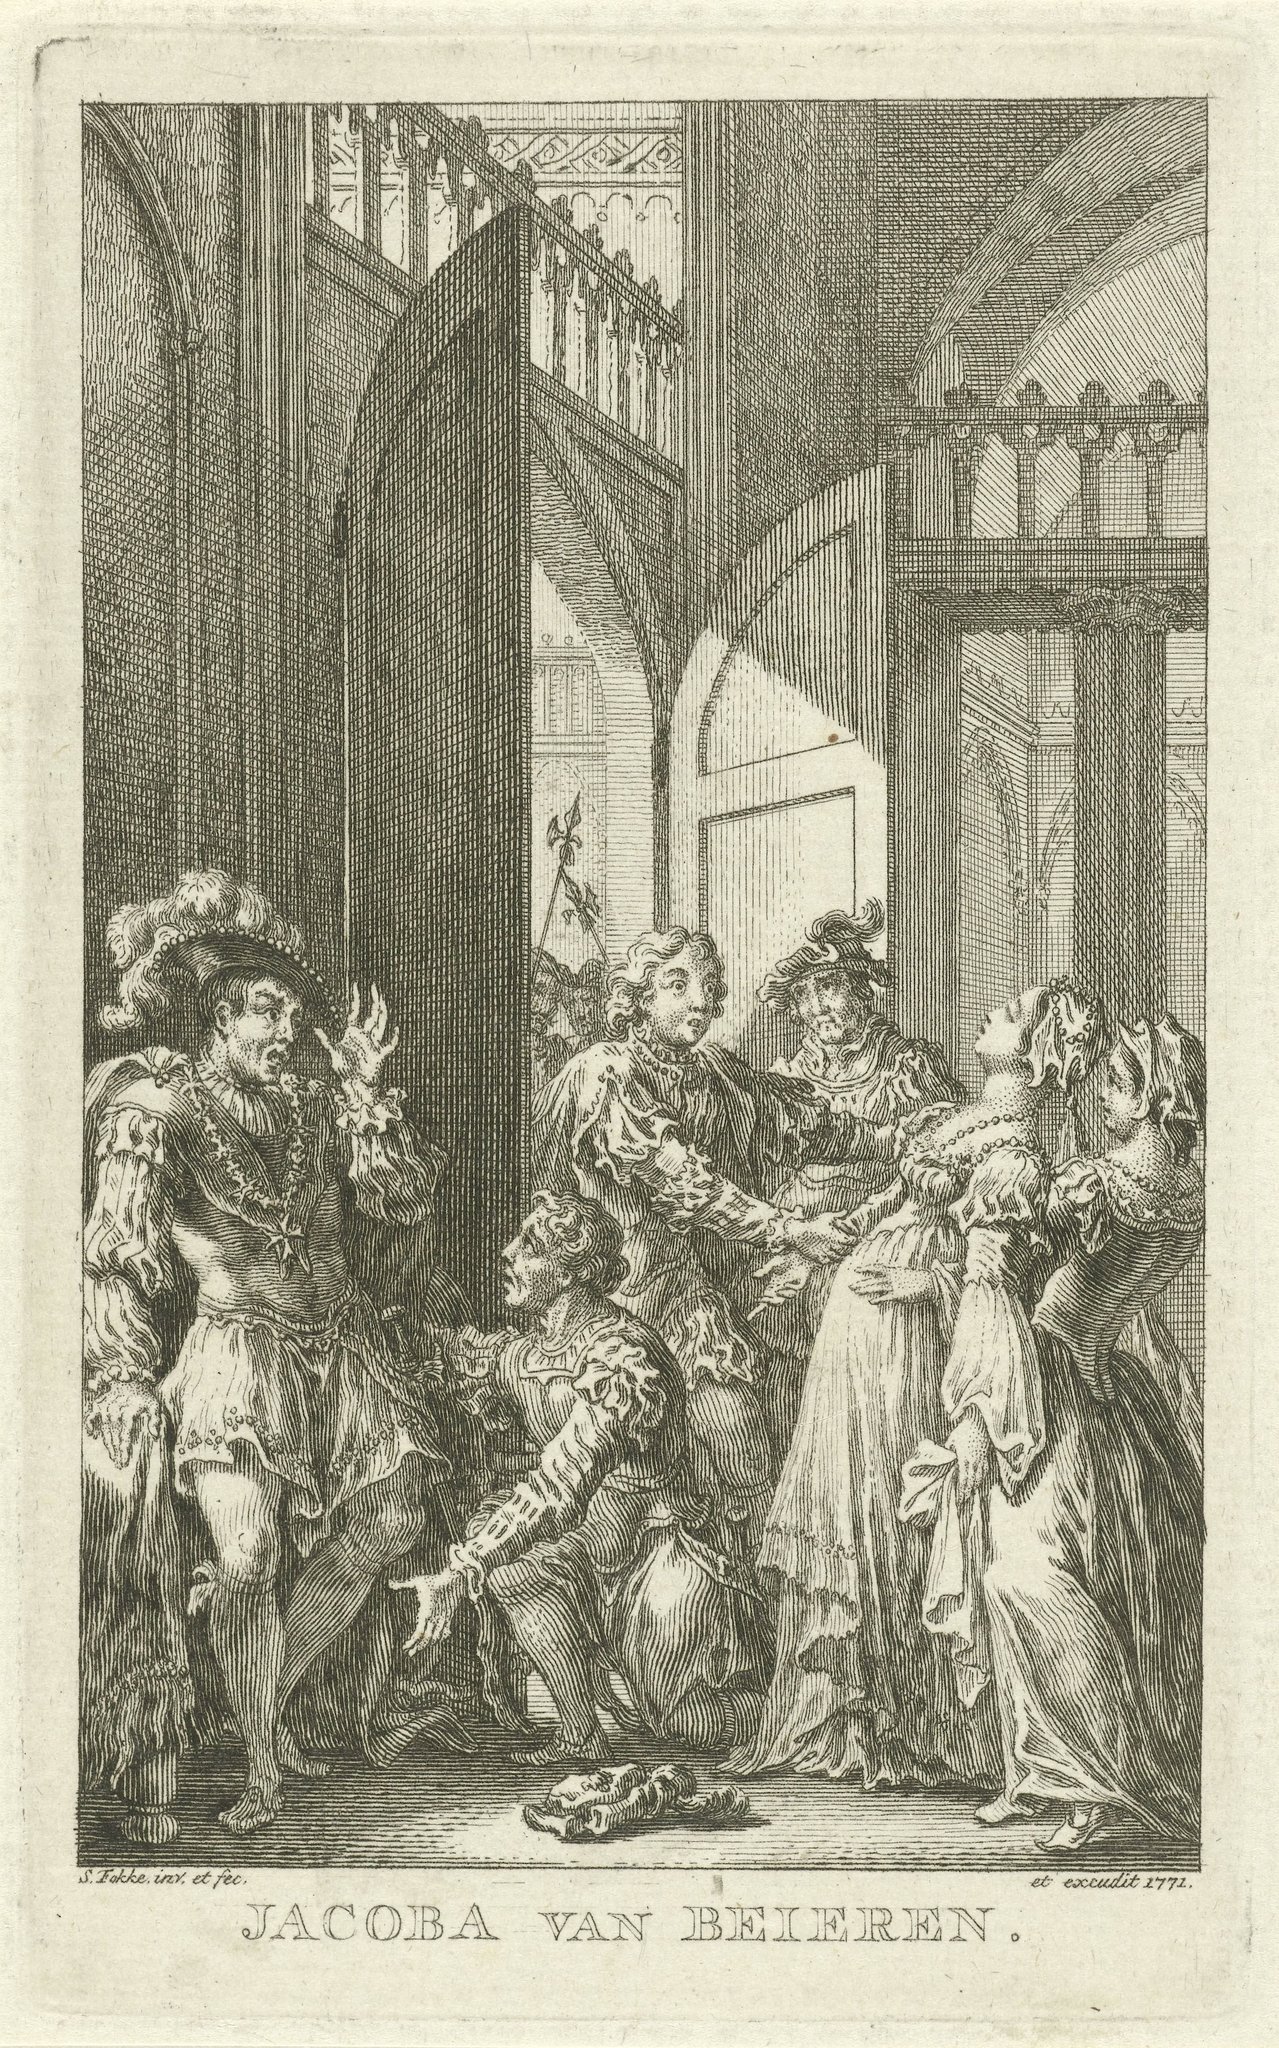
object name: print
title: Jacoba van Beieren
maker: simon fokke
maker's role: draughtsman, print maker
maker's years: 1712-1784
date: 1771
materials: paper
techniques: etching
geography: amsterdam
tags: fainting, swooning, tragedy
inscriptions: collector's mark: Lugt 2228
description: Jacoba van Beieren valt flauw bij het aanzien van een mannelijke gast. Ze wordt opgevangen door een vrouw die achter haar staat. Links naast de deur zijn twee edelmannen in gesprek. Deze prent is vervaardigd voor het treurspel "Jacoba van Beieren, gravin van Holland en Zeeland" van Jan de Marre.